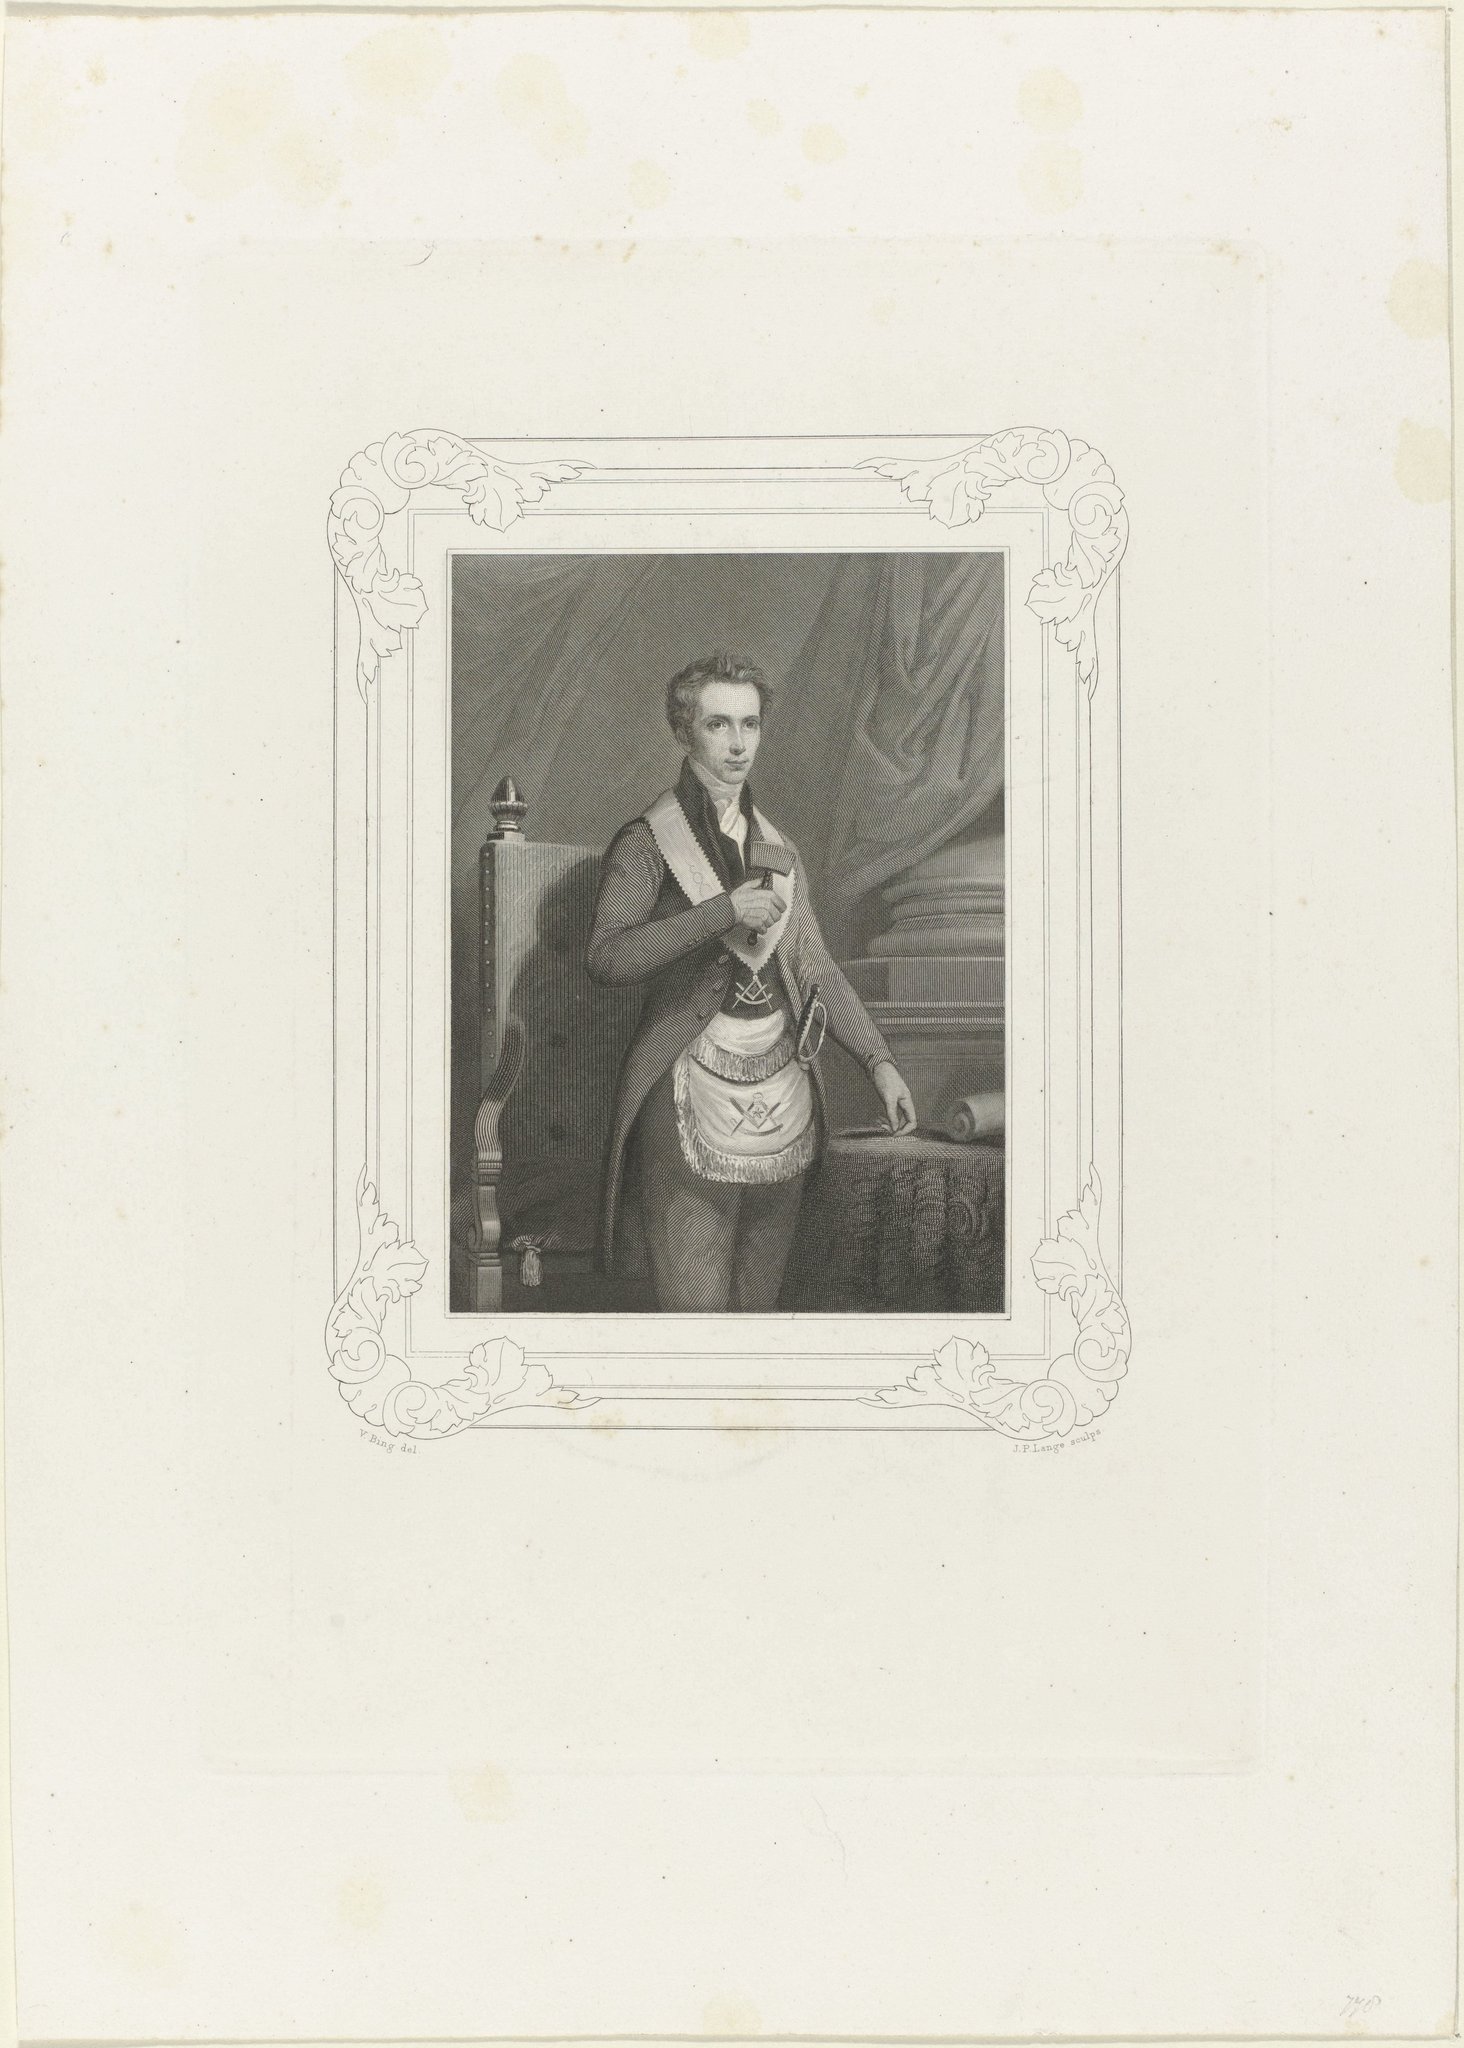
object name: print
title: Portret van Frederik, prins der Nederlanden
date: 1825-1849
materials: paper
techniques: engraving, etching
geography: amsterdam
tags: berlin, frederik (prins der nederlanden)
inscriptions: collector's mark: Lugt 963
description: Portret van Frederik als grootmeester der Vrijmetselaren in een geornamenteerde rechthoek. Hij staat naast een tafel met daarop een rol. In zijn rechterhand een hamer.